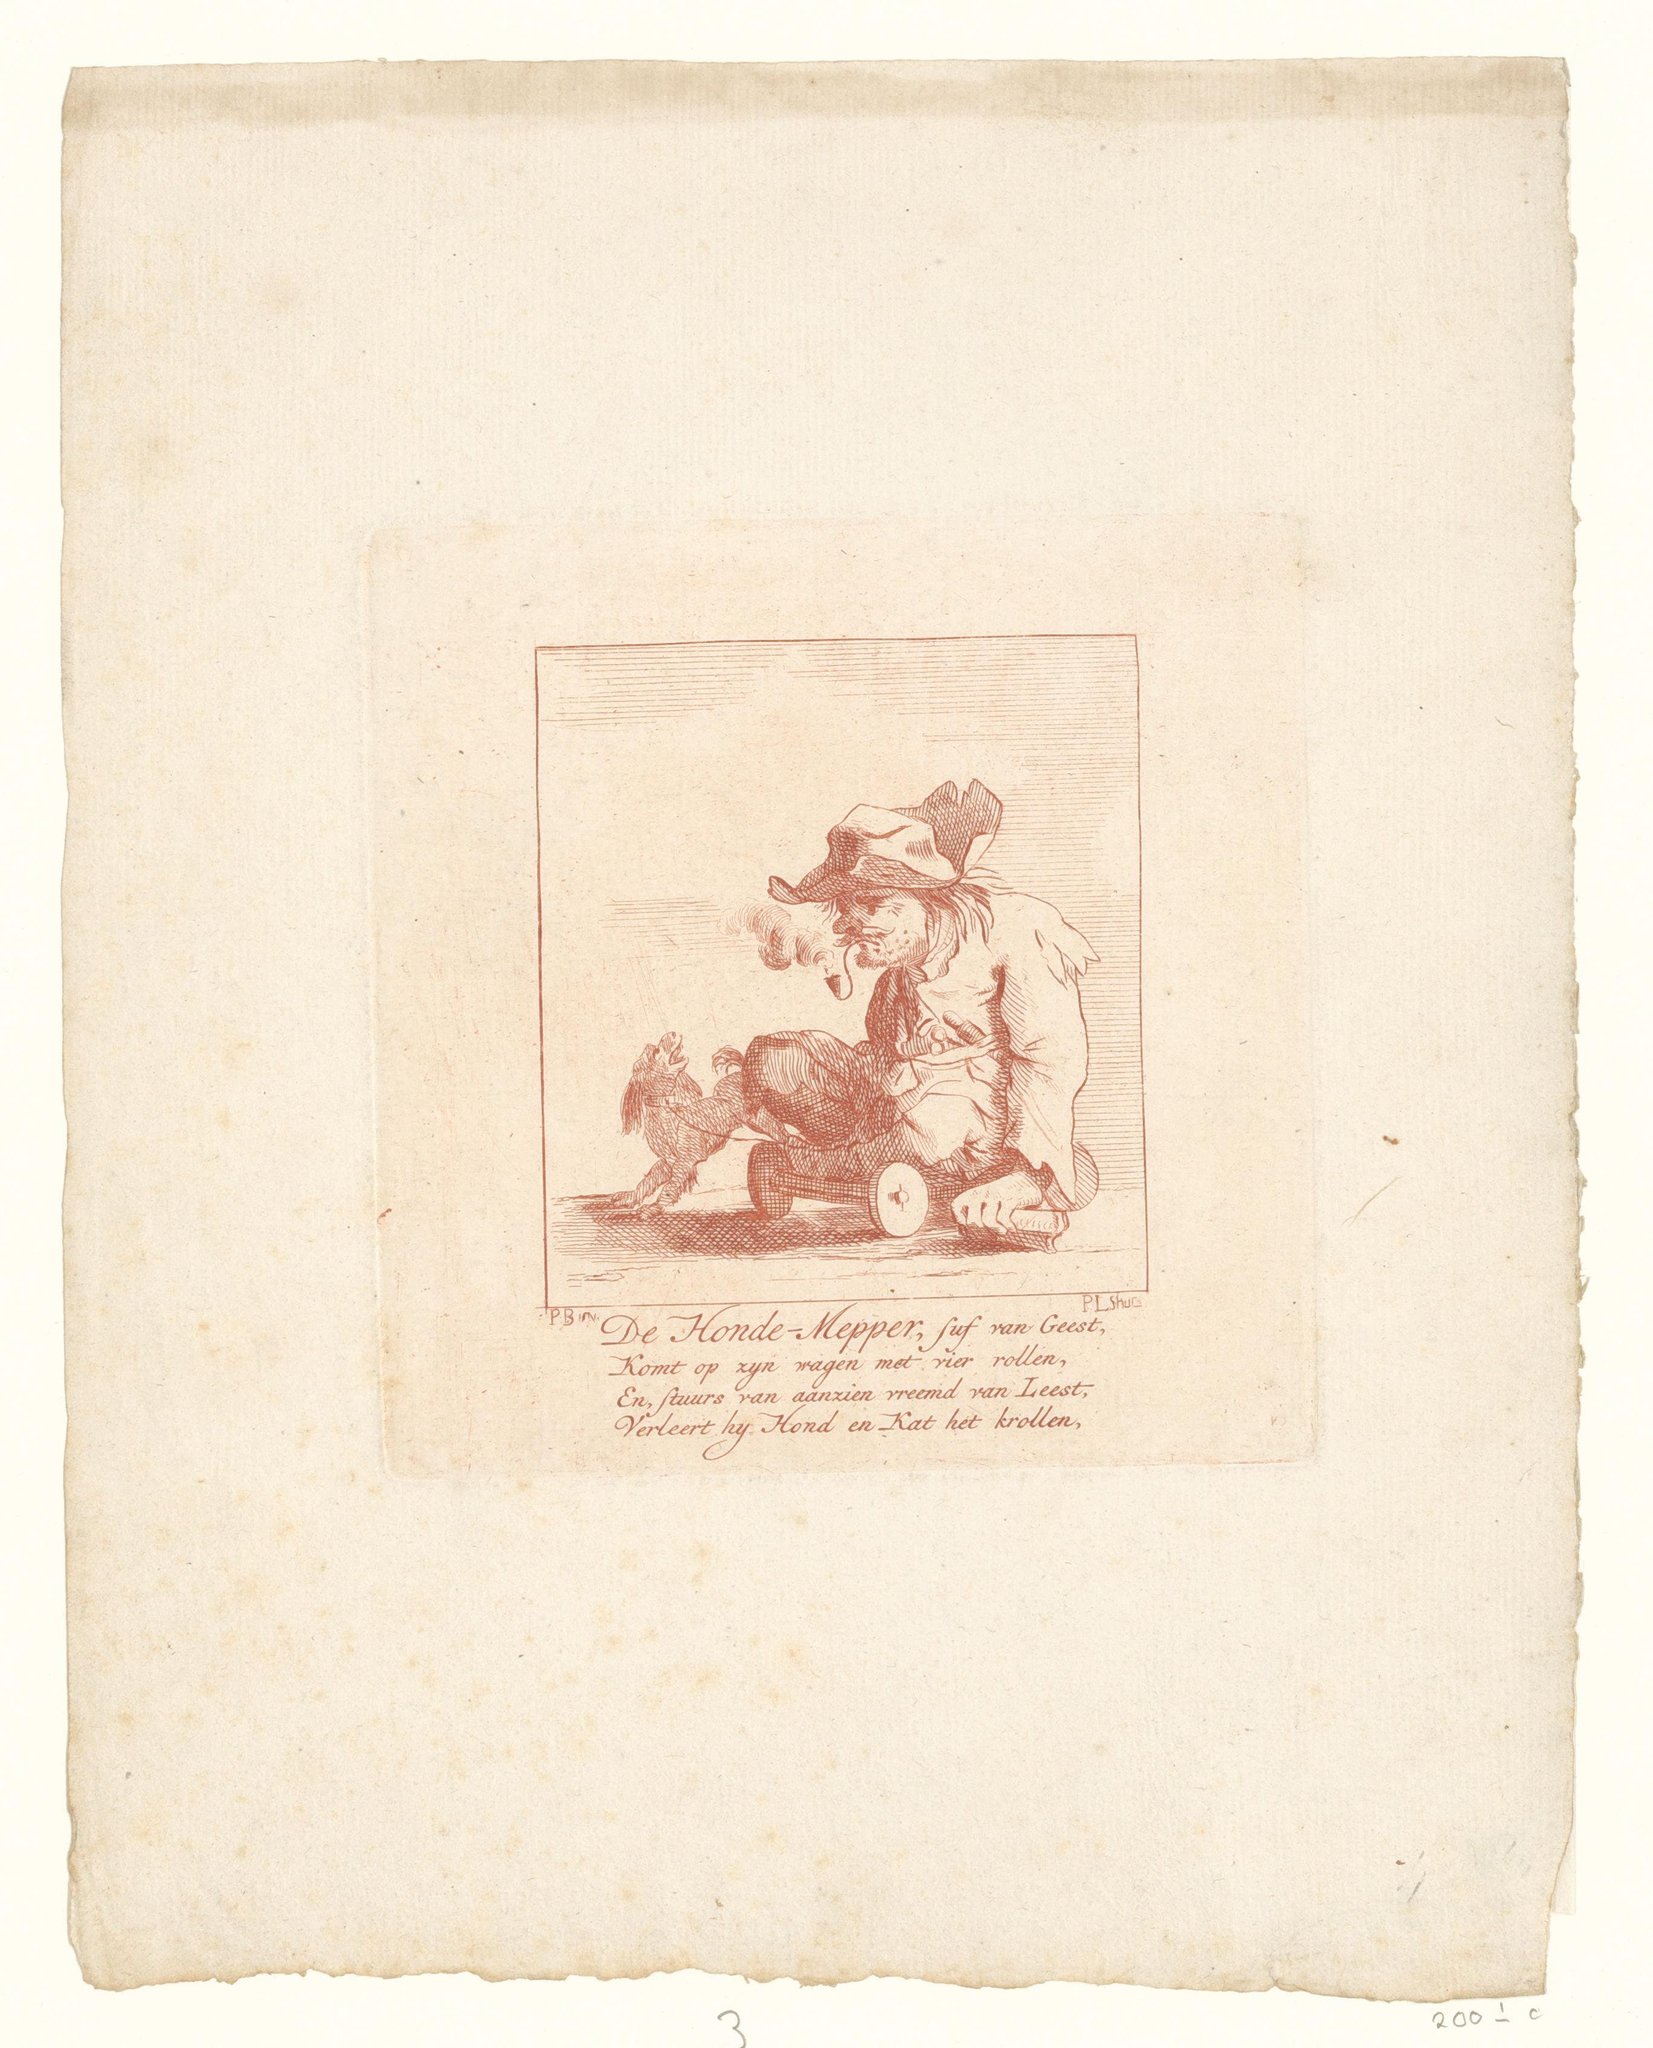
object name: print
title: Amsterdamse straatfiguren rond 1770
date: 1770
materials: paper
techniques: engraving, etching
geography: netherlands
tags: pipe ~ tobacco, person with a physical disability, beggar, dog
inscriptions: collector's mark: Lugt 1641, collector's mark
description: Een bedelaar zit op een lage kar met wielen pijp te roken en wordt vergezeld door een hond. In de marge een vierregelig vers in het Nederlands. Onderdeel van een serie prenten van Amsterdamse straatfiguren rond 1770. Onderwerpsrubrieken binnen de Atlas Zeden en Gewoonten: Mannelijk beroep en bedrijf: Marskramers, straatventers, straatslijpers, bedelaars, straatvertooningen enz.